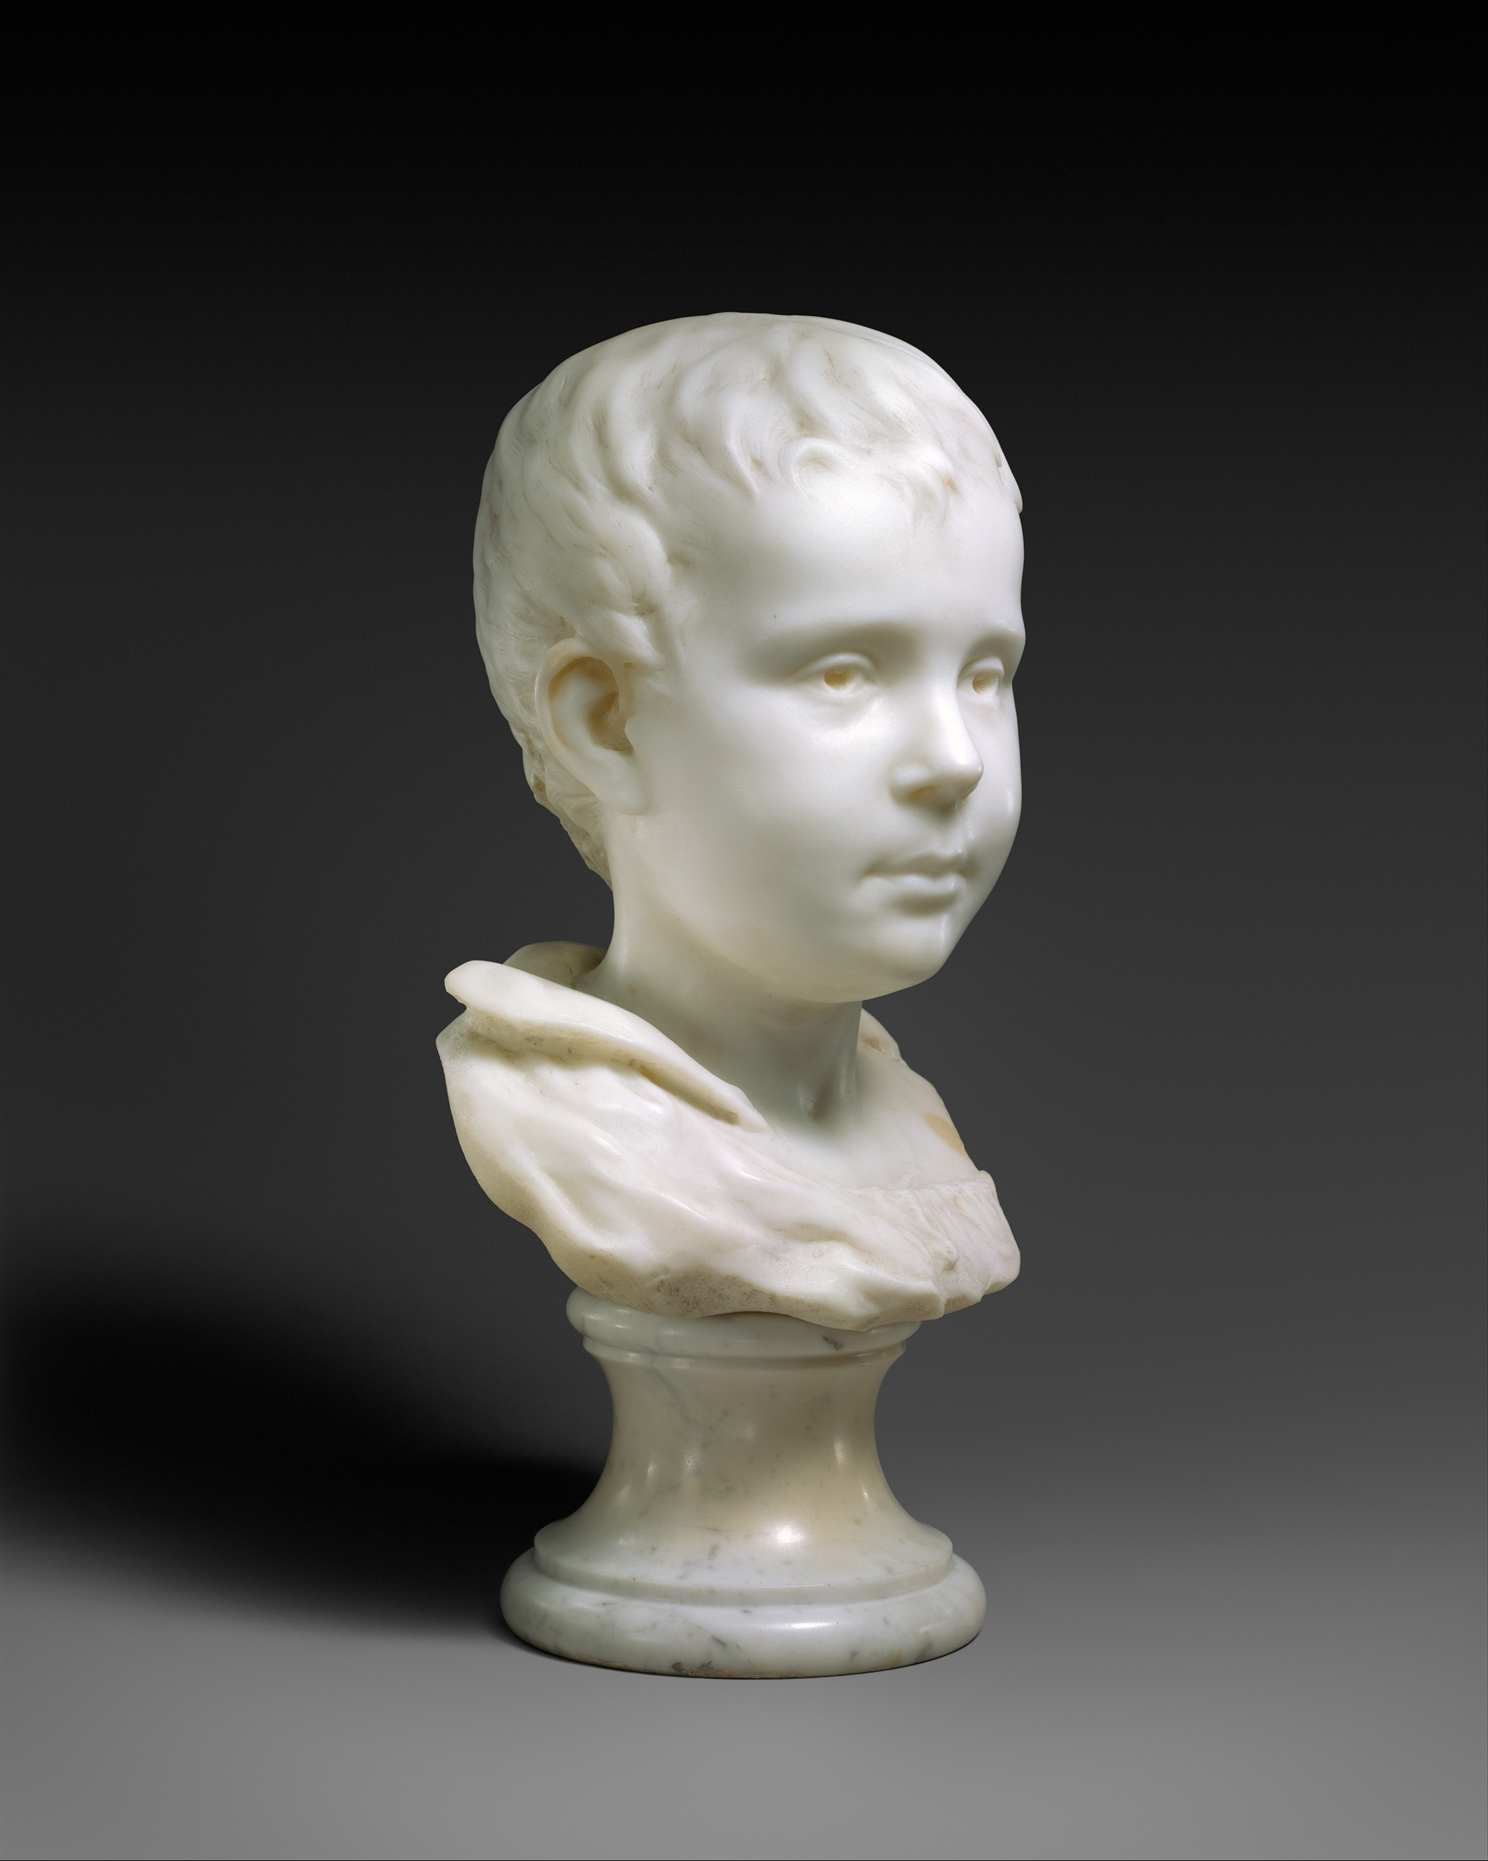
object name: bust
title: Emile Gauguin (1874–1955), the artist's son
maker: paul gauguin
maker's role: artist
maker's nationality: french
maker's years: 1848-1903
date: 1877-1878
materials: marble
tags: boys